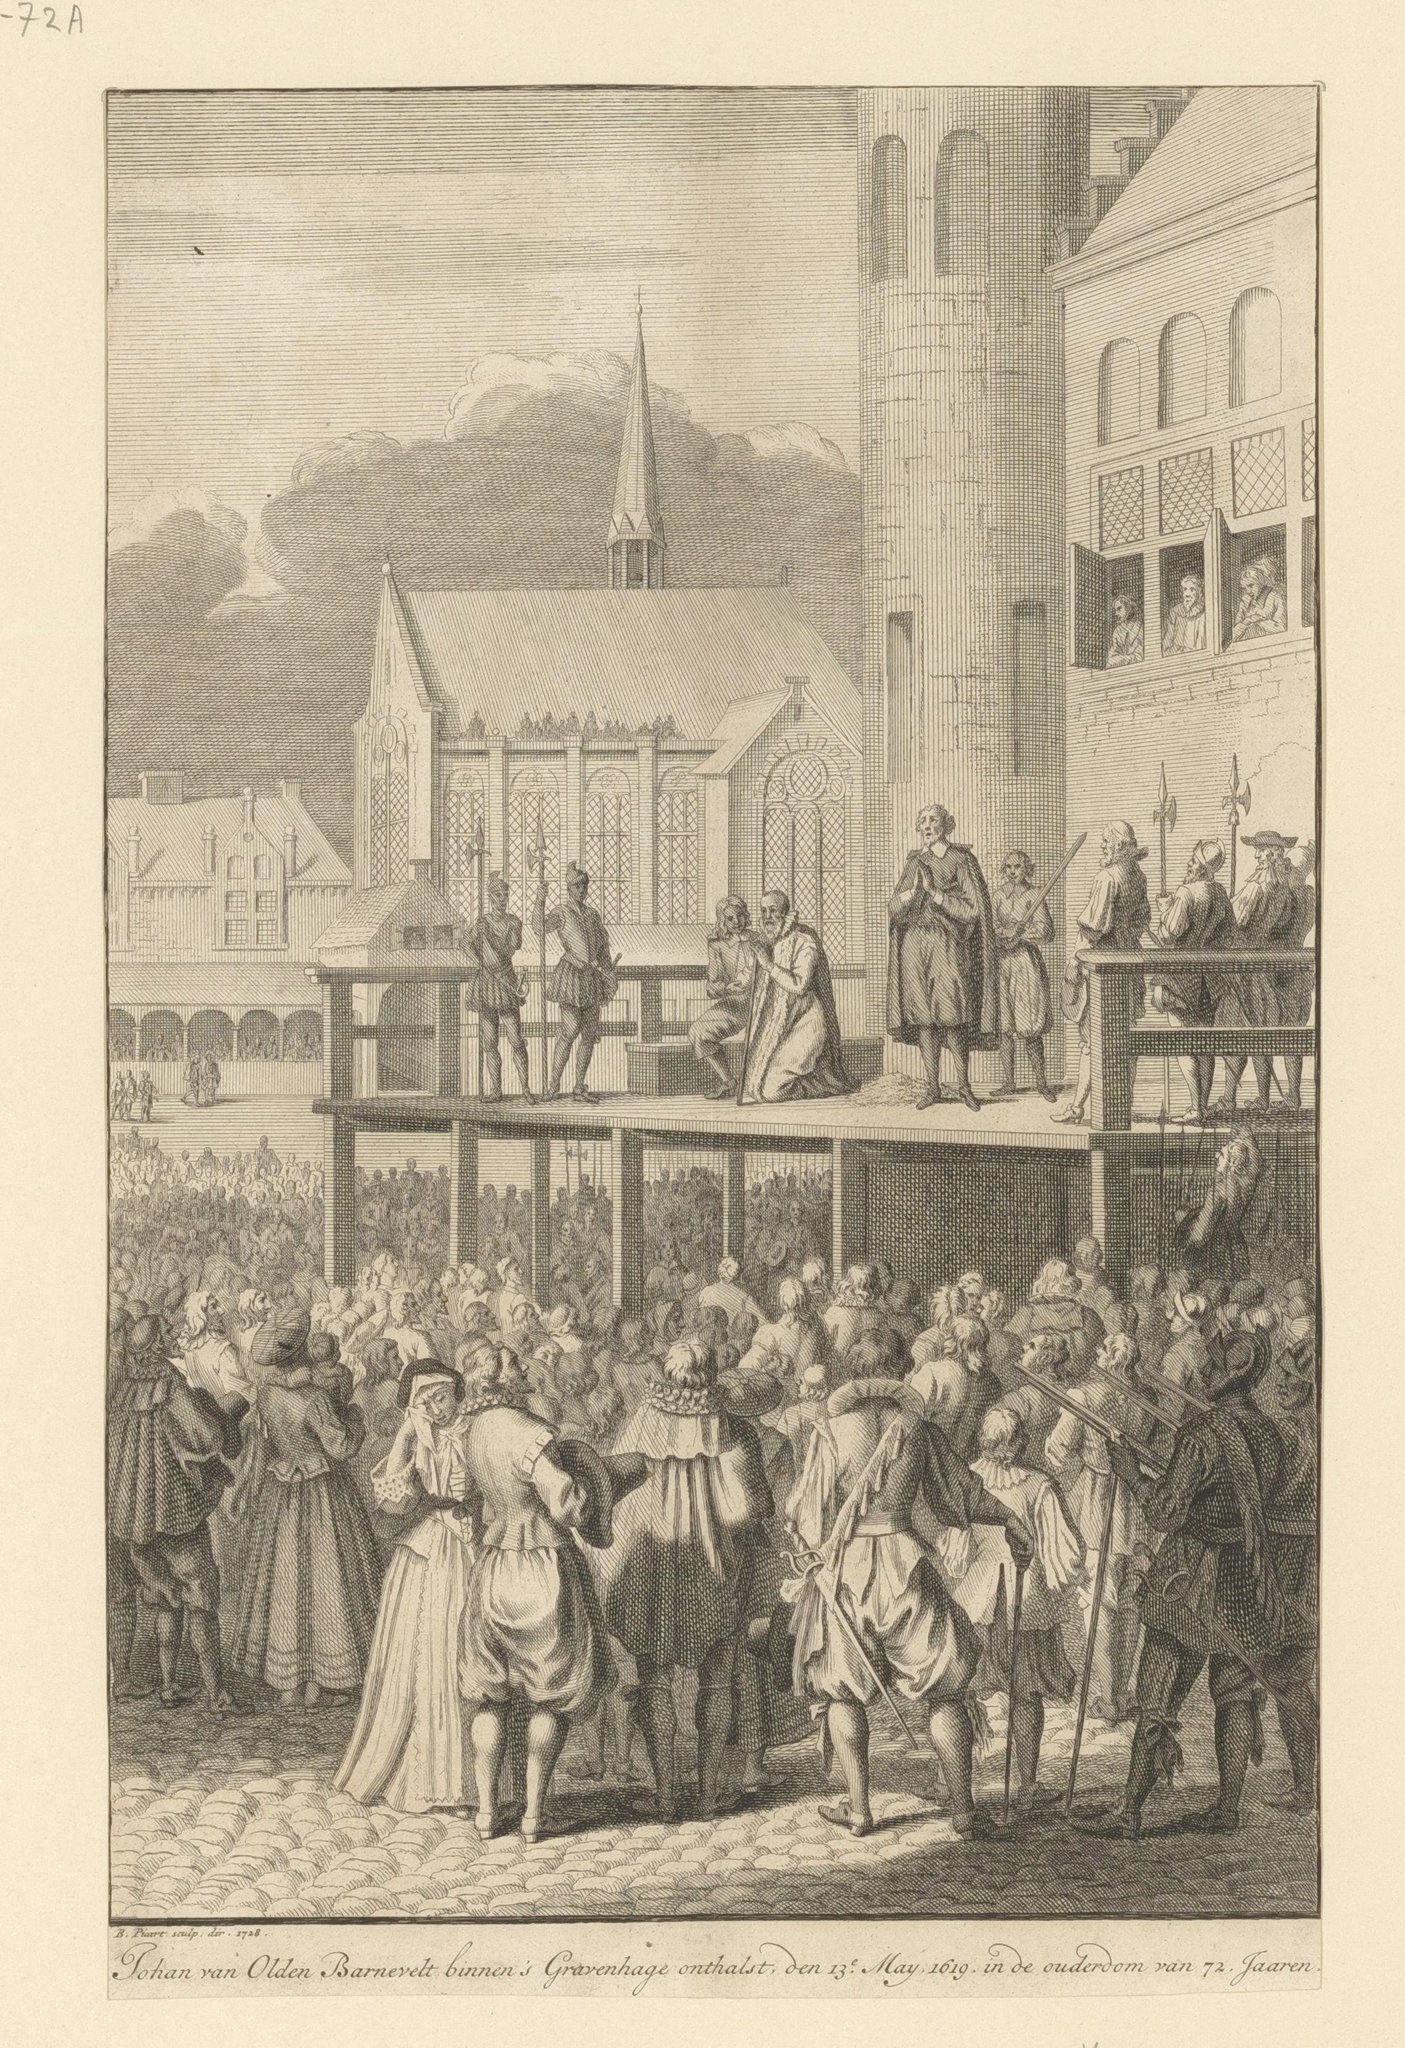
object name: print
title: Johan van Oldenbarnevelt knielt voor zijn onthoofding, 1619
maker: bernard picart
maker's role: draughtsman, print maker, publisher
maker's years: 1673-1733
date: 1728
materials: paper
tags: johan van oldenbarnevelt, maurice (prince of orange), on the scaffold or place of execution, violent death by beheading, the hague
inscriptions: collector's mark: Lugt 1641, stamp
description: Johan van Oldenbarnevelt knielt voor zijn onthoofding op het Binnenhof te Den Haag op 13 mei 1619. Zijn knecht Jan Francken knielt aan zijn zijde op het schavot, een predikant houdt een gebed. Op het plein de verzamelde toeschouwers. Onderwerpsrubrieken binnen de Atlas Zeden en Gewoonten: Regeering, Rechtswezen.